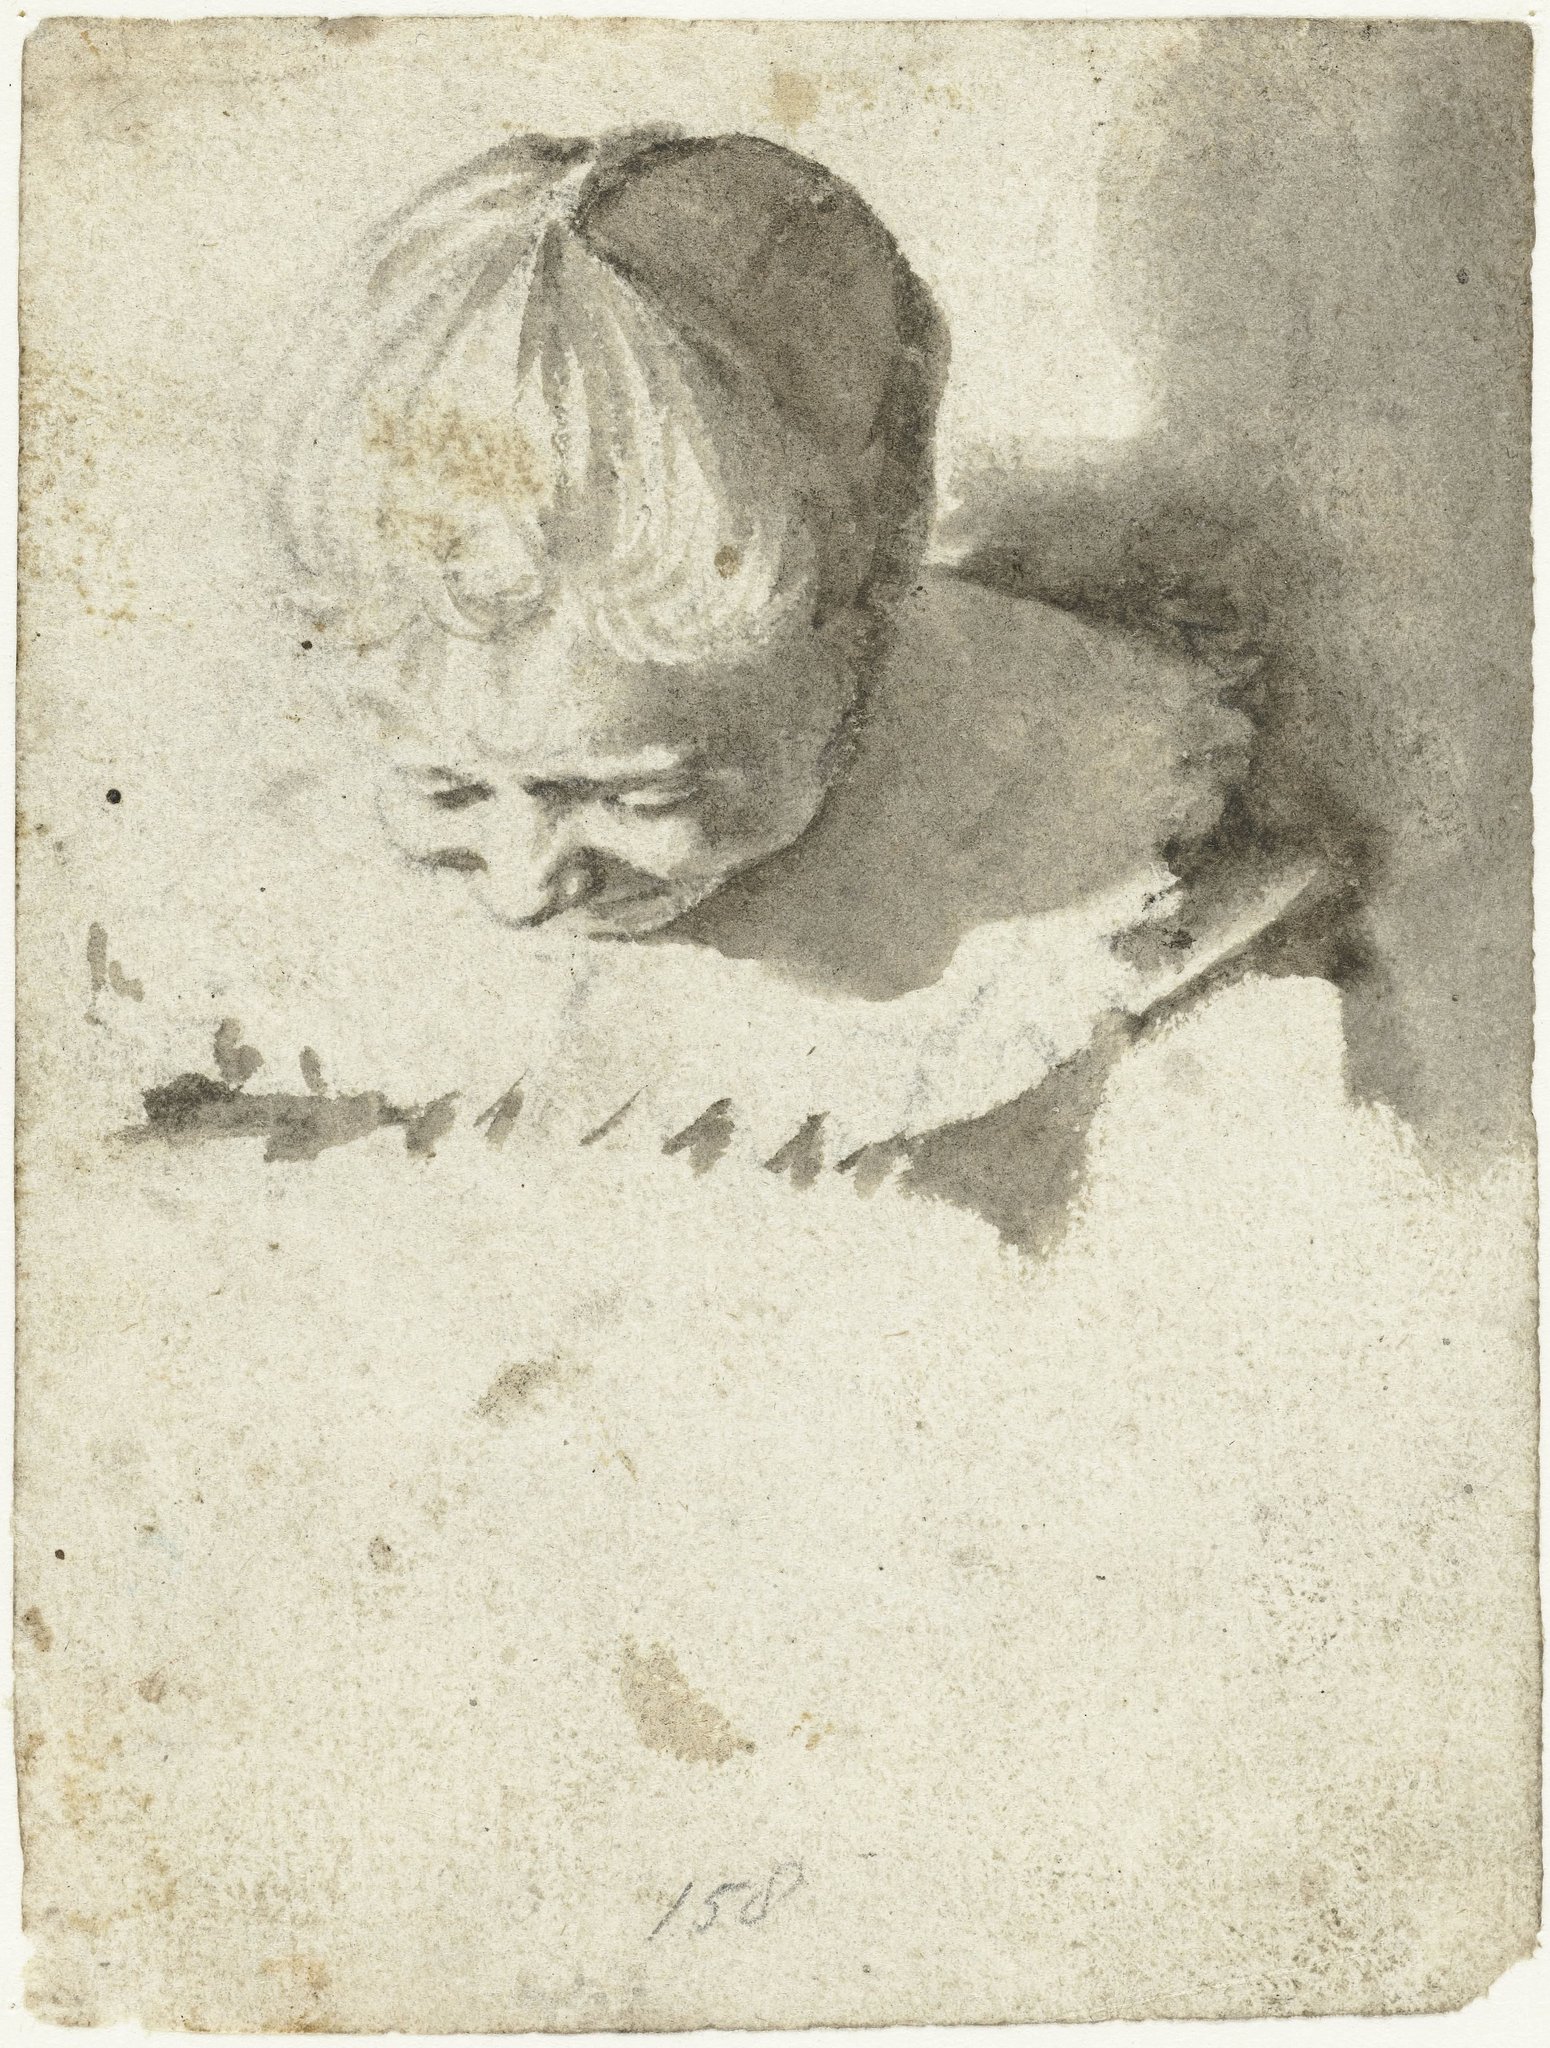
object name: drawing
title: Studieblad met kop en schouders van een meisje, van bovenaf gezien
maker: gerard ter borch (ii)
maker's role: draughtsman, painter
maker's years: 1617-1681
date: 1633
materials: chalk, ink, paper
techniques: brush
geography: zwolle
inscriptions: date: ‘[1]5 December 1633’, annotation: ‘Ger Sr; G ter Borch Sr’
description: Tegelijkertijd met GJr 31 en 32 naar het leven getekend; misschien was zijn halfzusje Sara het model.